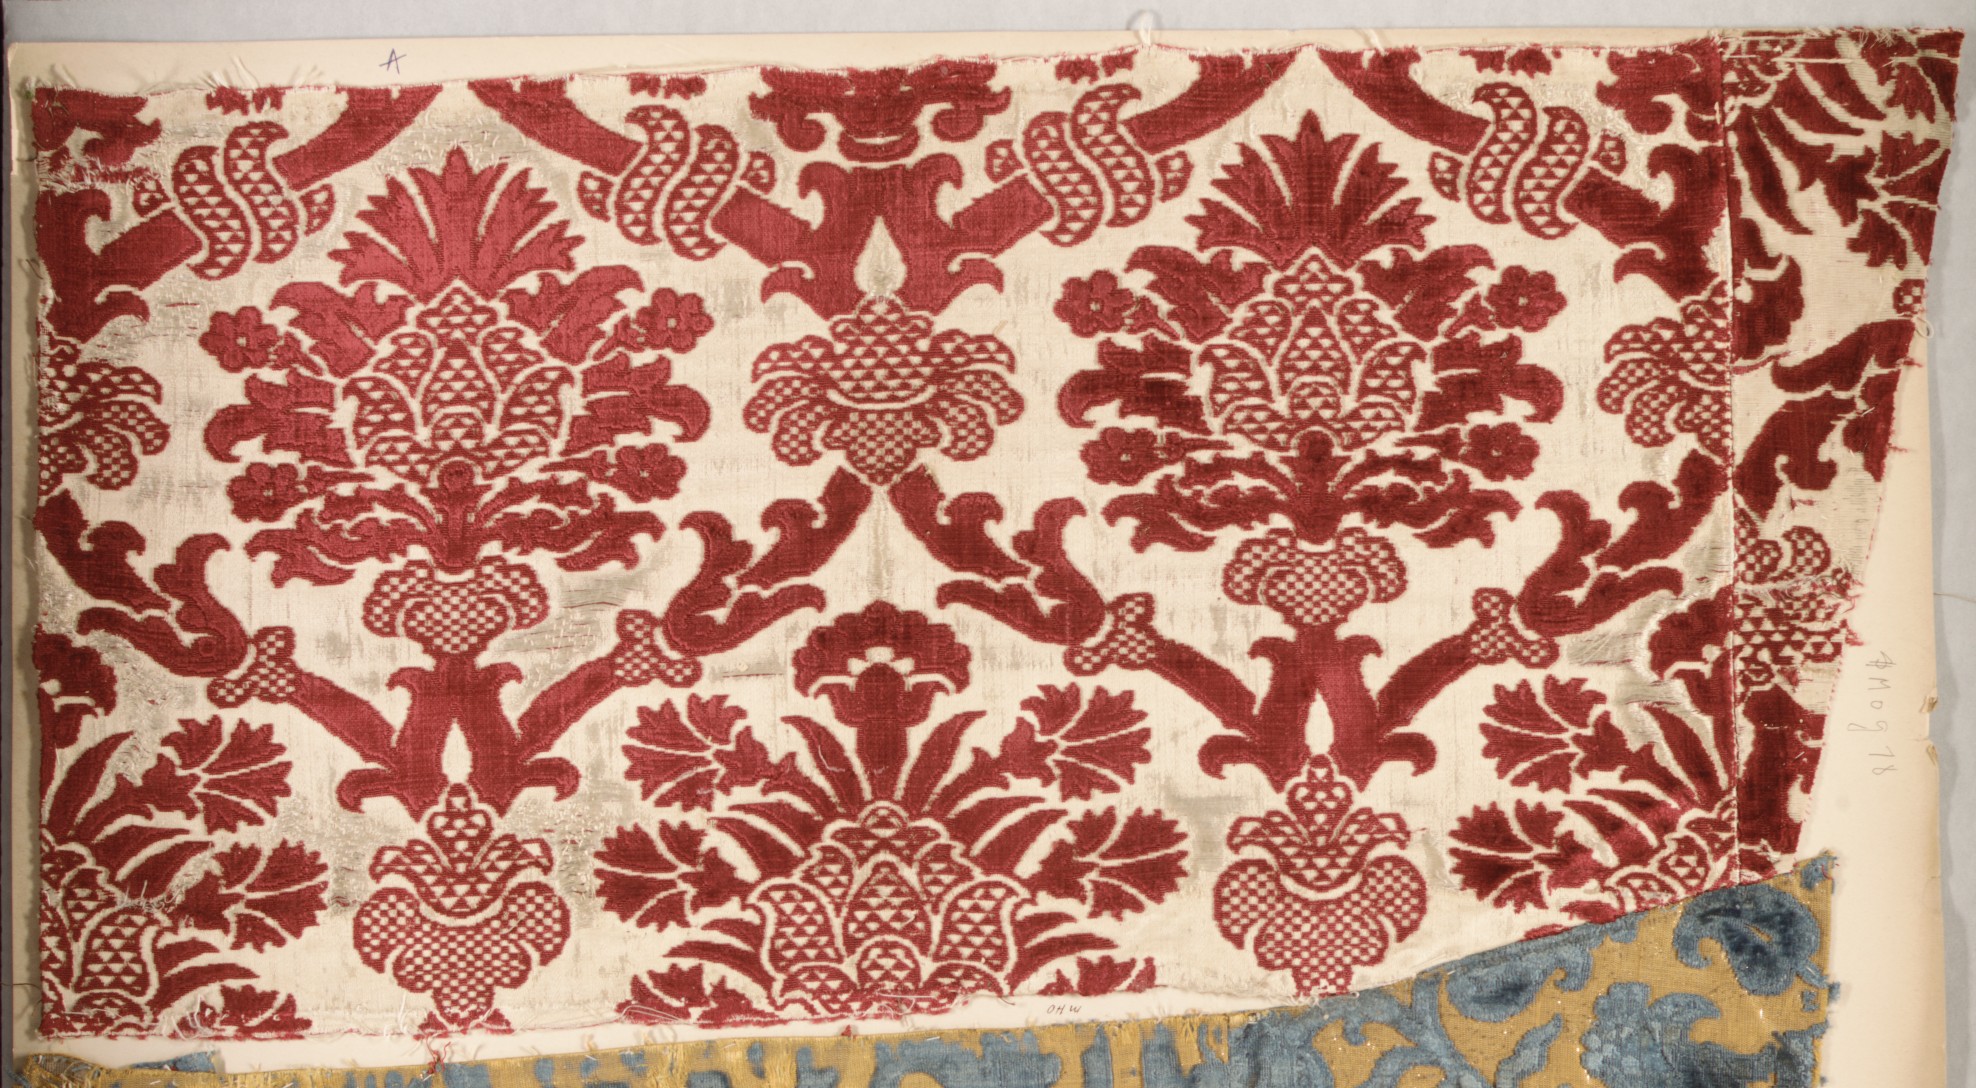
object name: fragment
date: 1601-1700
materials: silk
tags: flowers,leaves